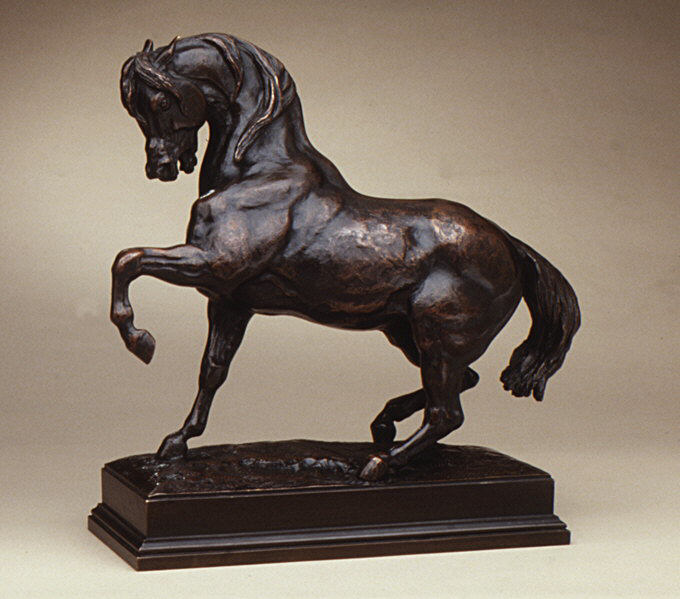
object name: statuette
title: Turkish Horse, Left Foot Raised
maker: antoine-louis barye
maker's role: artist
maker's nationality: french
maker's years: 1795-1875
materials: bronze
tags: horses